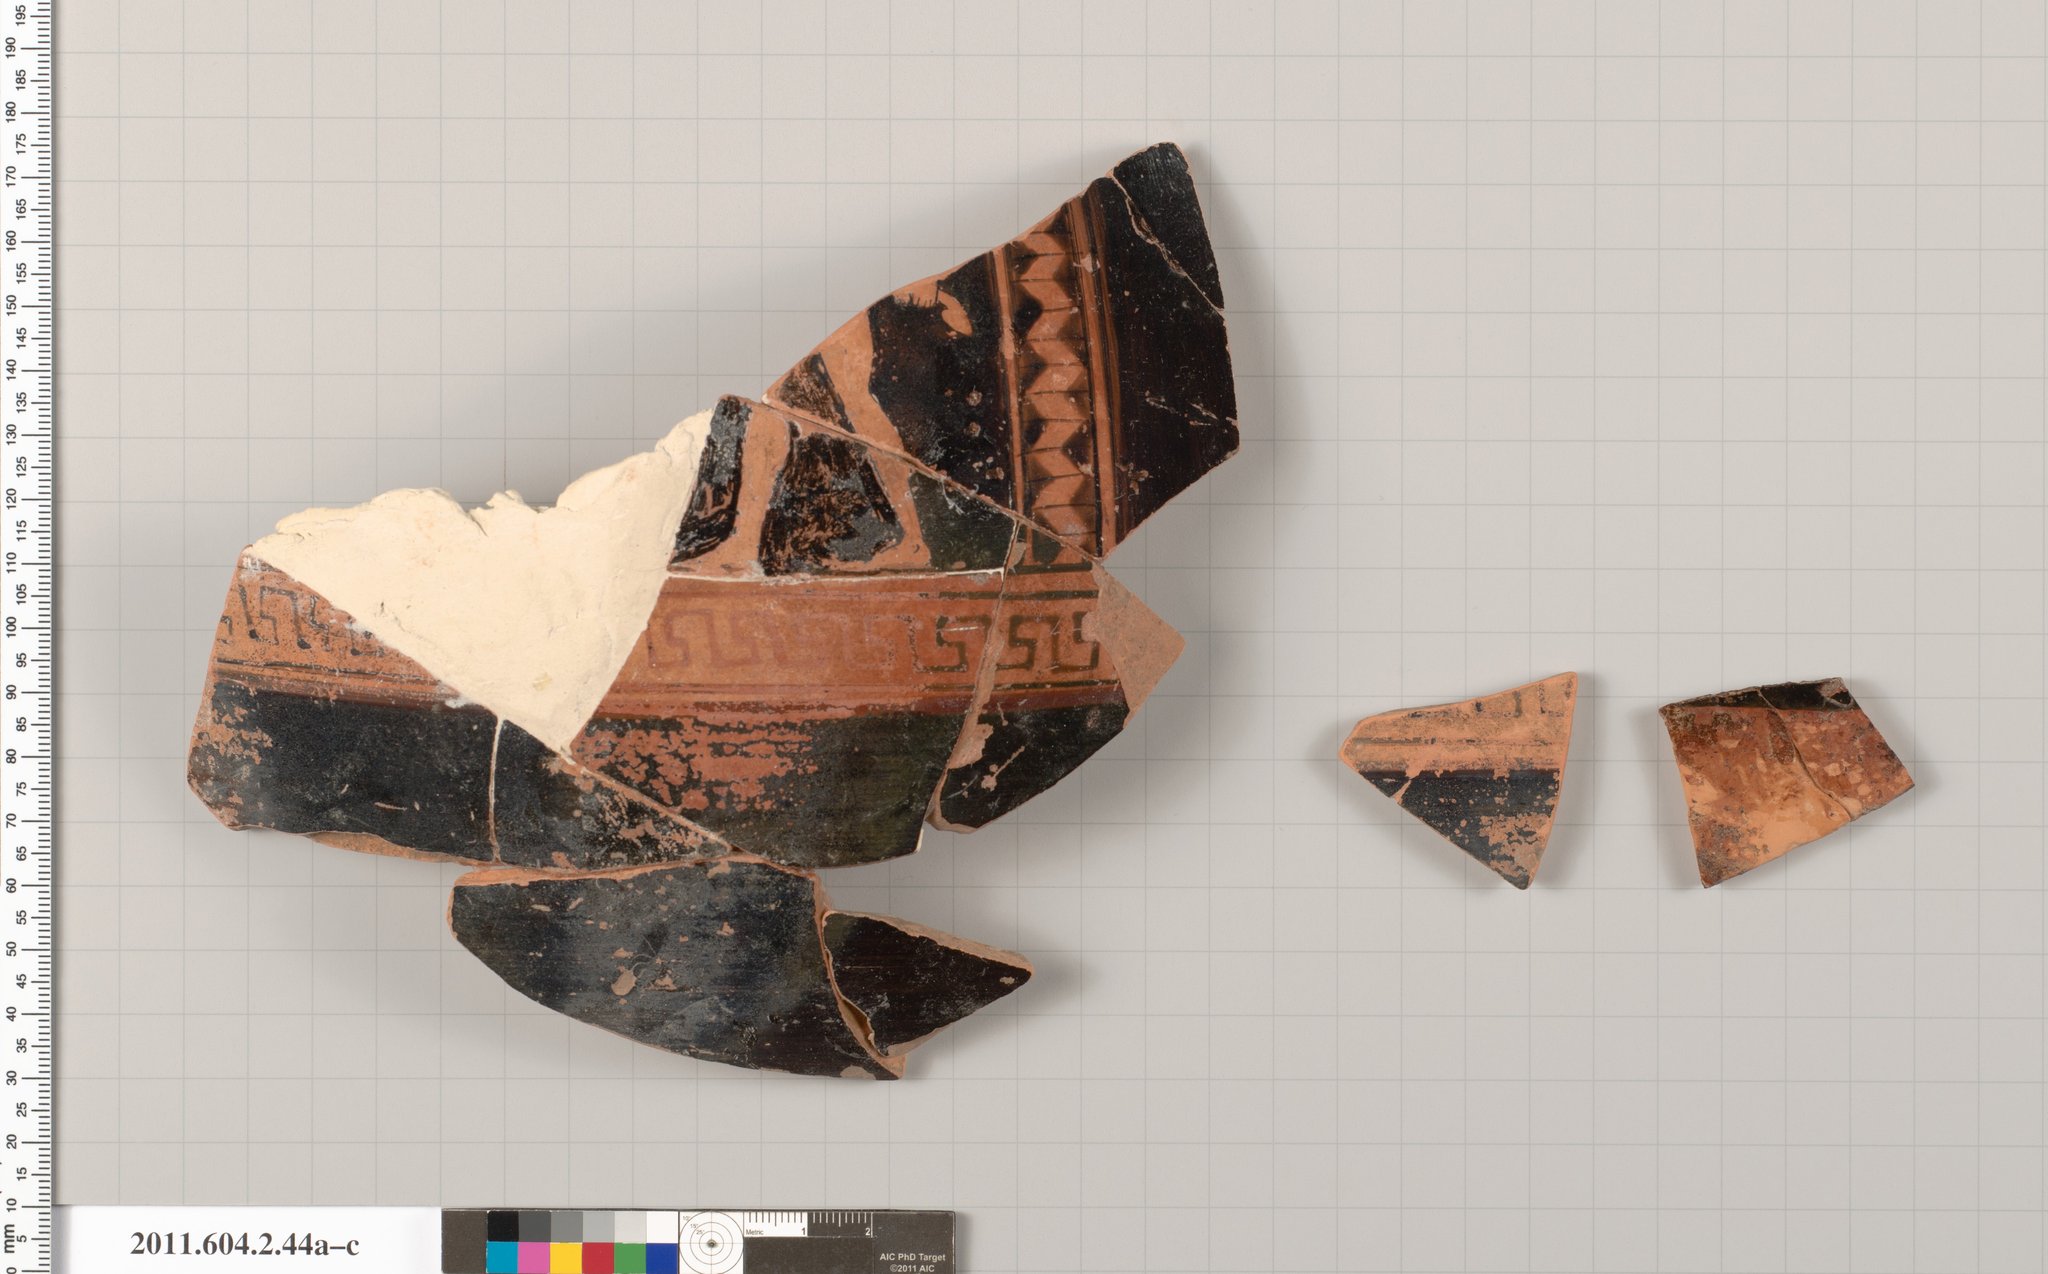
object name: pelike fragment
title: Terracotta fragments of a pelike (jar)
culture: greek, attic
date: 534-468 BCE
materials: terracotta